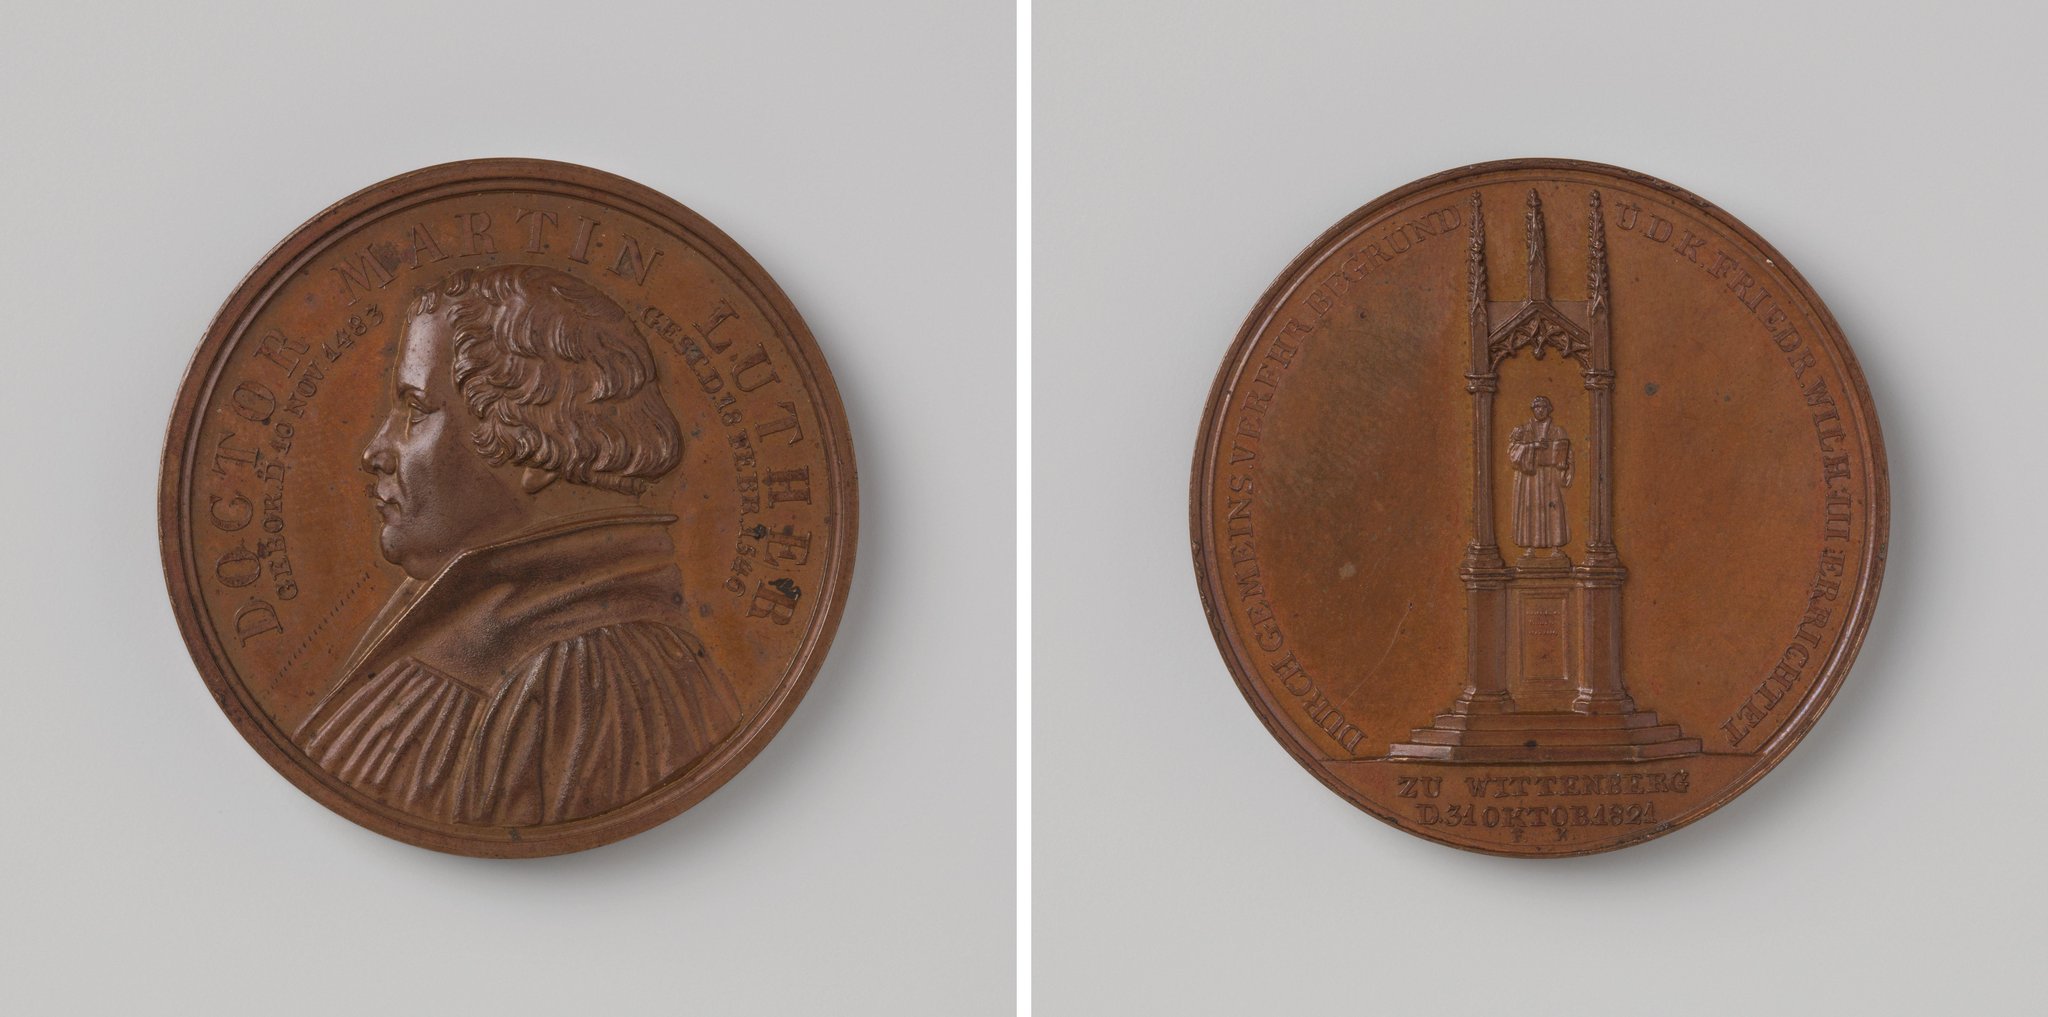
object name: history medal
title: Oprichting van een monument ter ere van Martin Luther te Wittenberg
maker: anton friedrich könig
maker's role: print maker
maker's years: 1756-1838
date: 1821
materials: bronze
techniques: striking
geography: berlin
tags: priest, martin luther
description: Bronzen penning. Voorzijde: borststuk man binnen tweeregelig omschrift. Keerzijde: standbeeld van Luther onder baldakein binnen omschrift; afsnede: opschrift